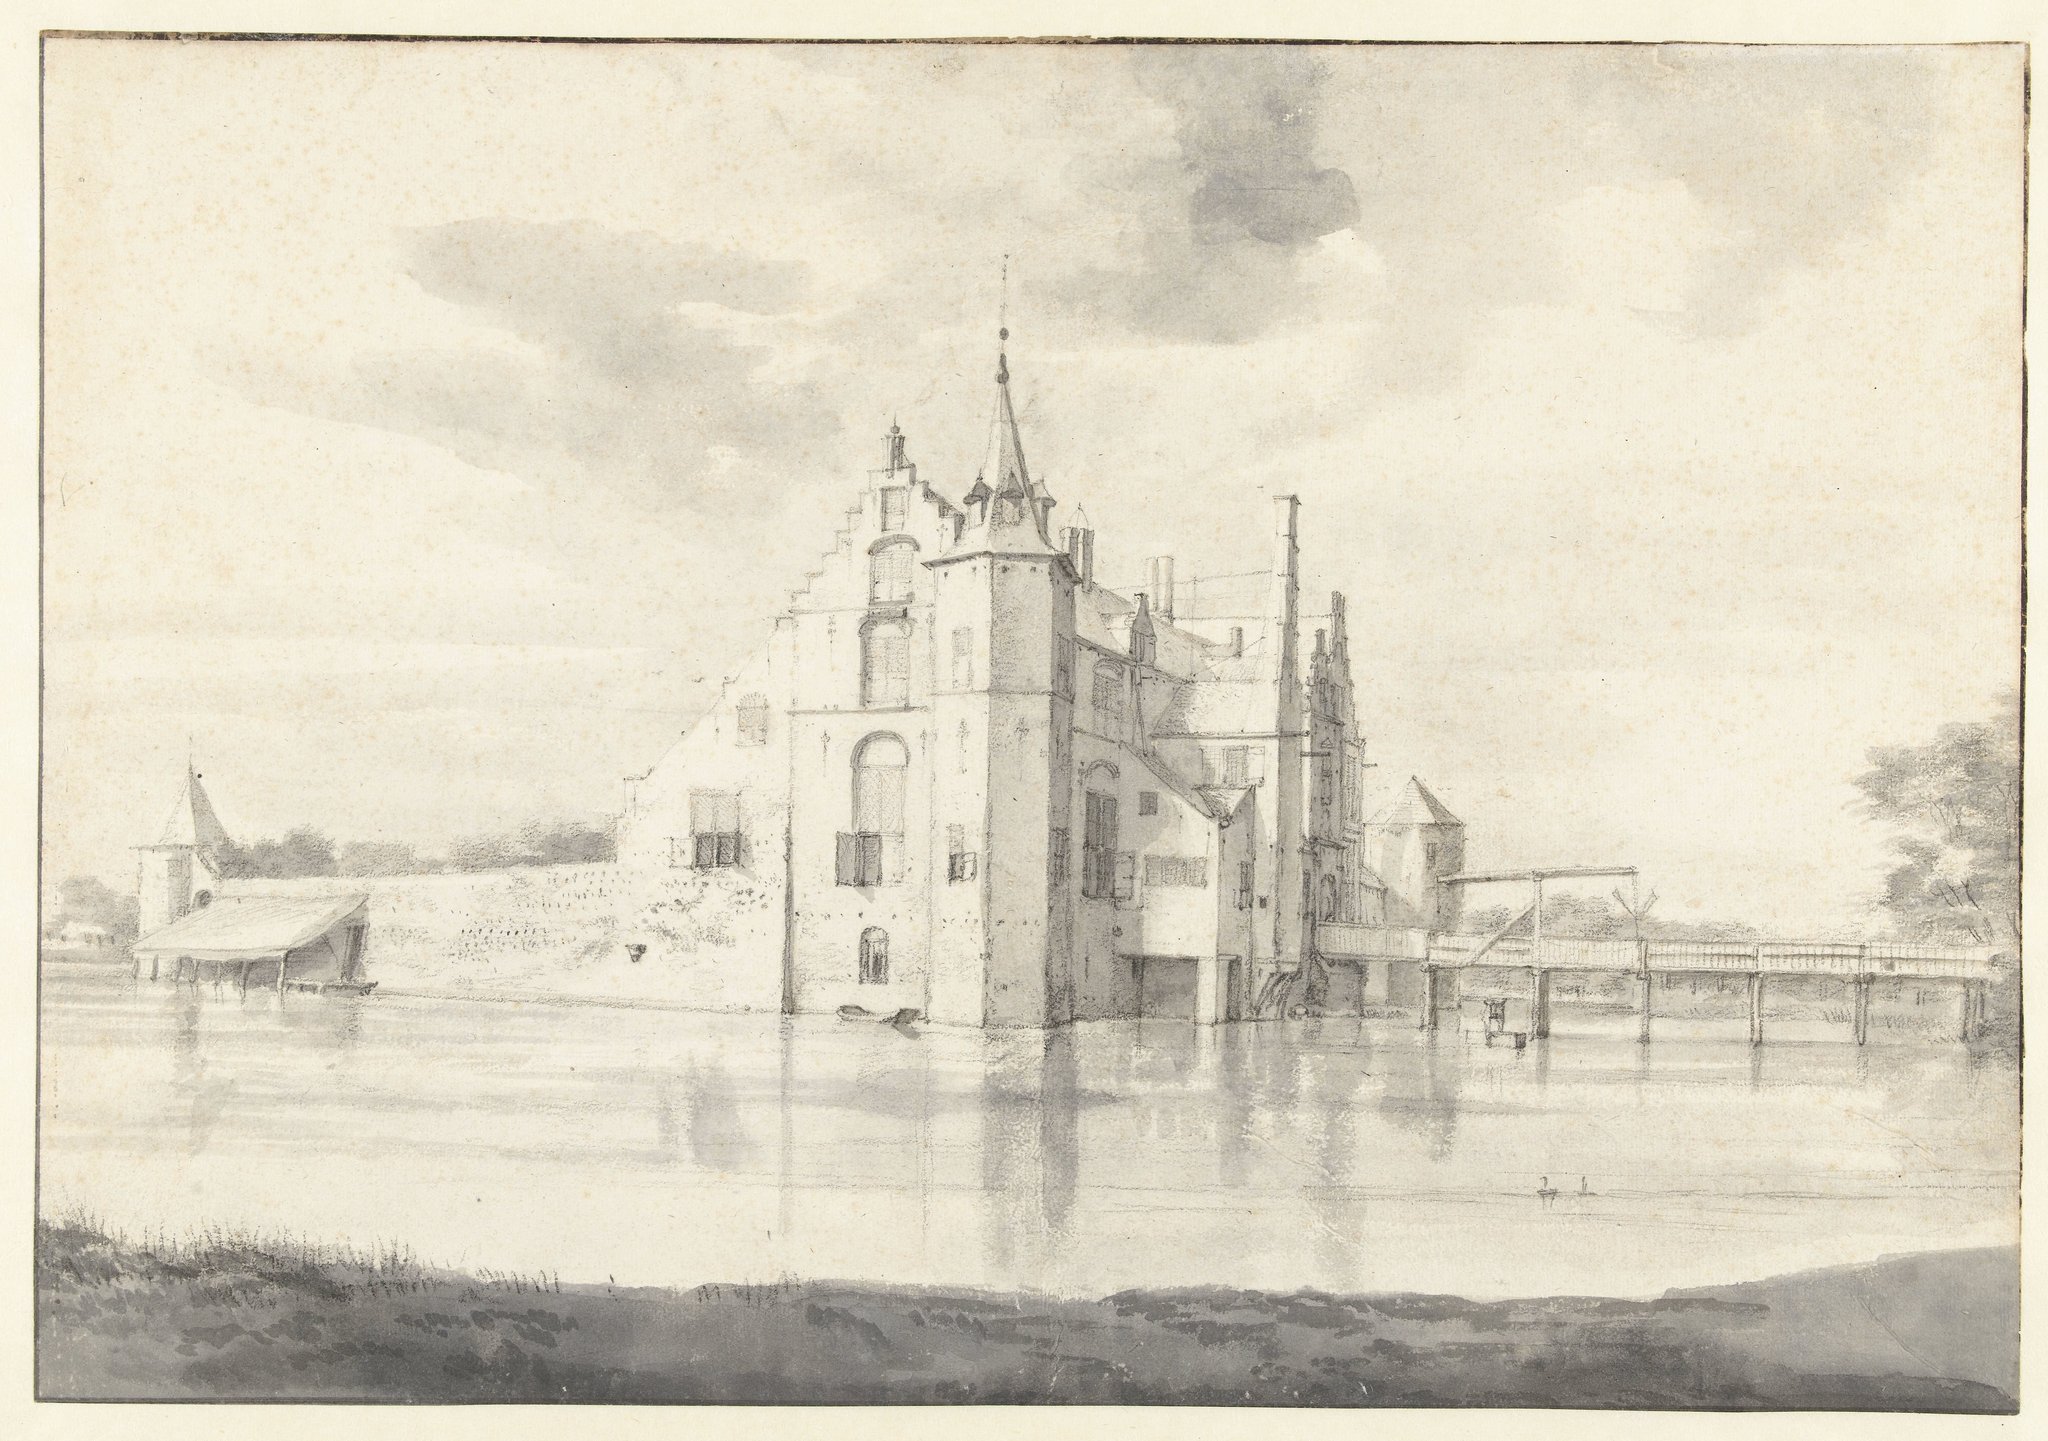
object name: drawing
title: View of Huis Geervliet (Hof van Putten), Seen from the North-east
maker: roelant roghman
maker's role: draughtsman, painter, print maker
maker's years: 1627-1692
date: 1646-1647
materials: chalk, ink, paper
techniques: brush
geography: geervliet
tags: castle